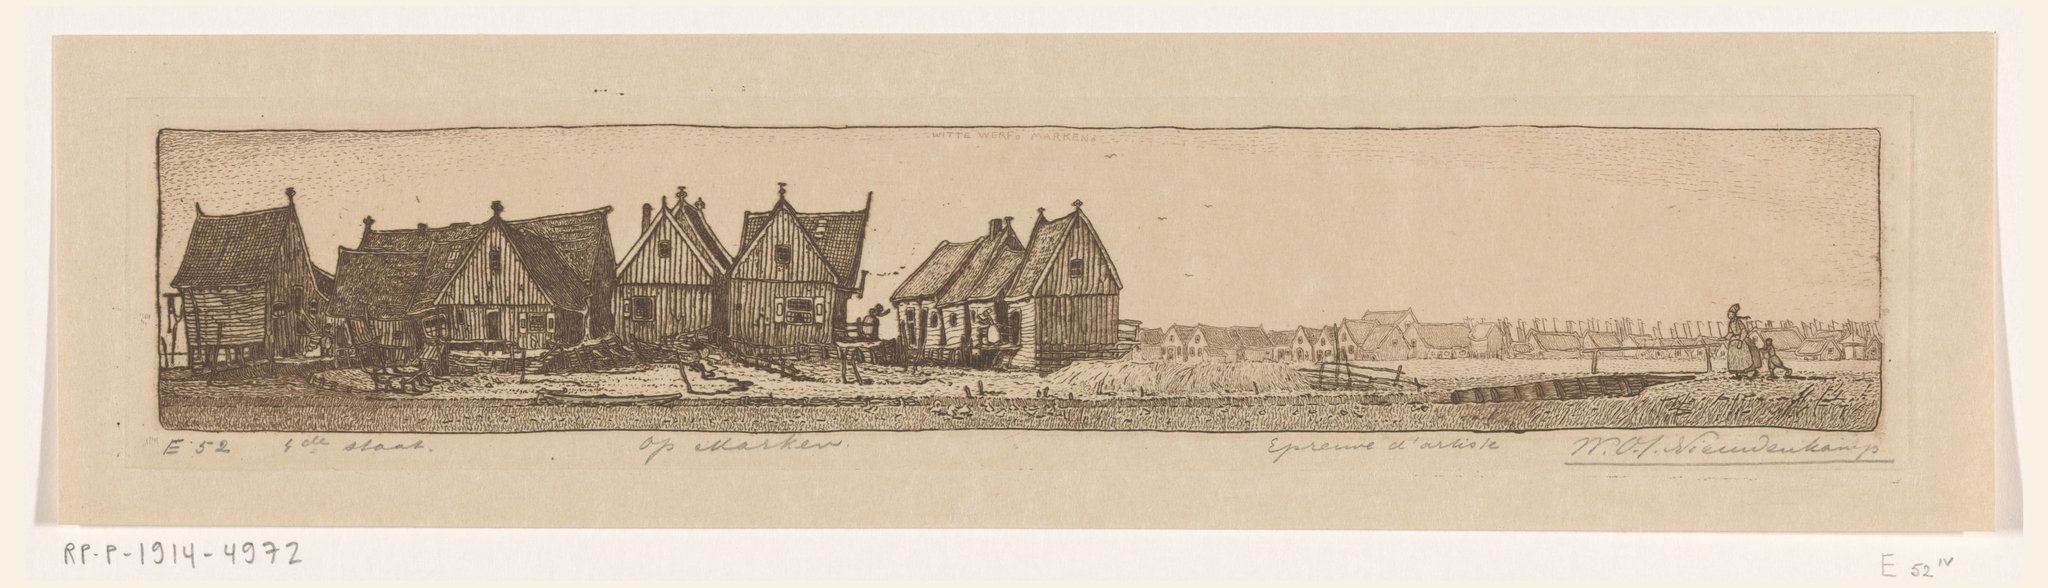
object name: print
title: Zicht op het eiland Marken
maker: wijnand otto jan nieuwenkamp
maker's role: draughtsman, print maker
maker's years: 1874-1950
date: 1900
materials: paper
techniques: intaglio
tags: village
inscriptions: collector's mark: Lugt 2233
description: De Wittewerf op het eiland Marken. Op de achtergrond de Havenbuurt.